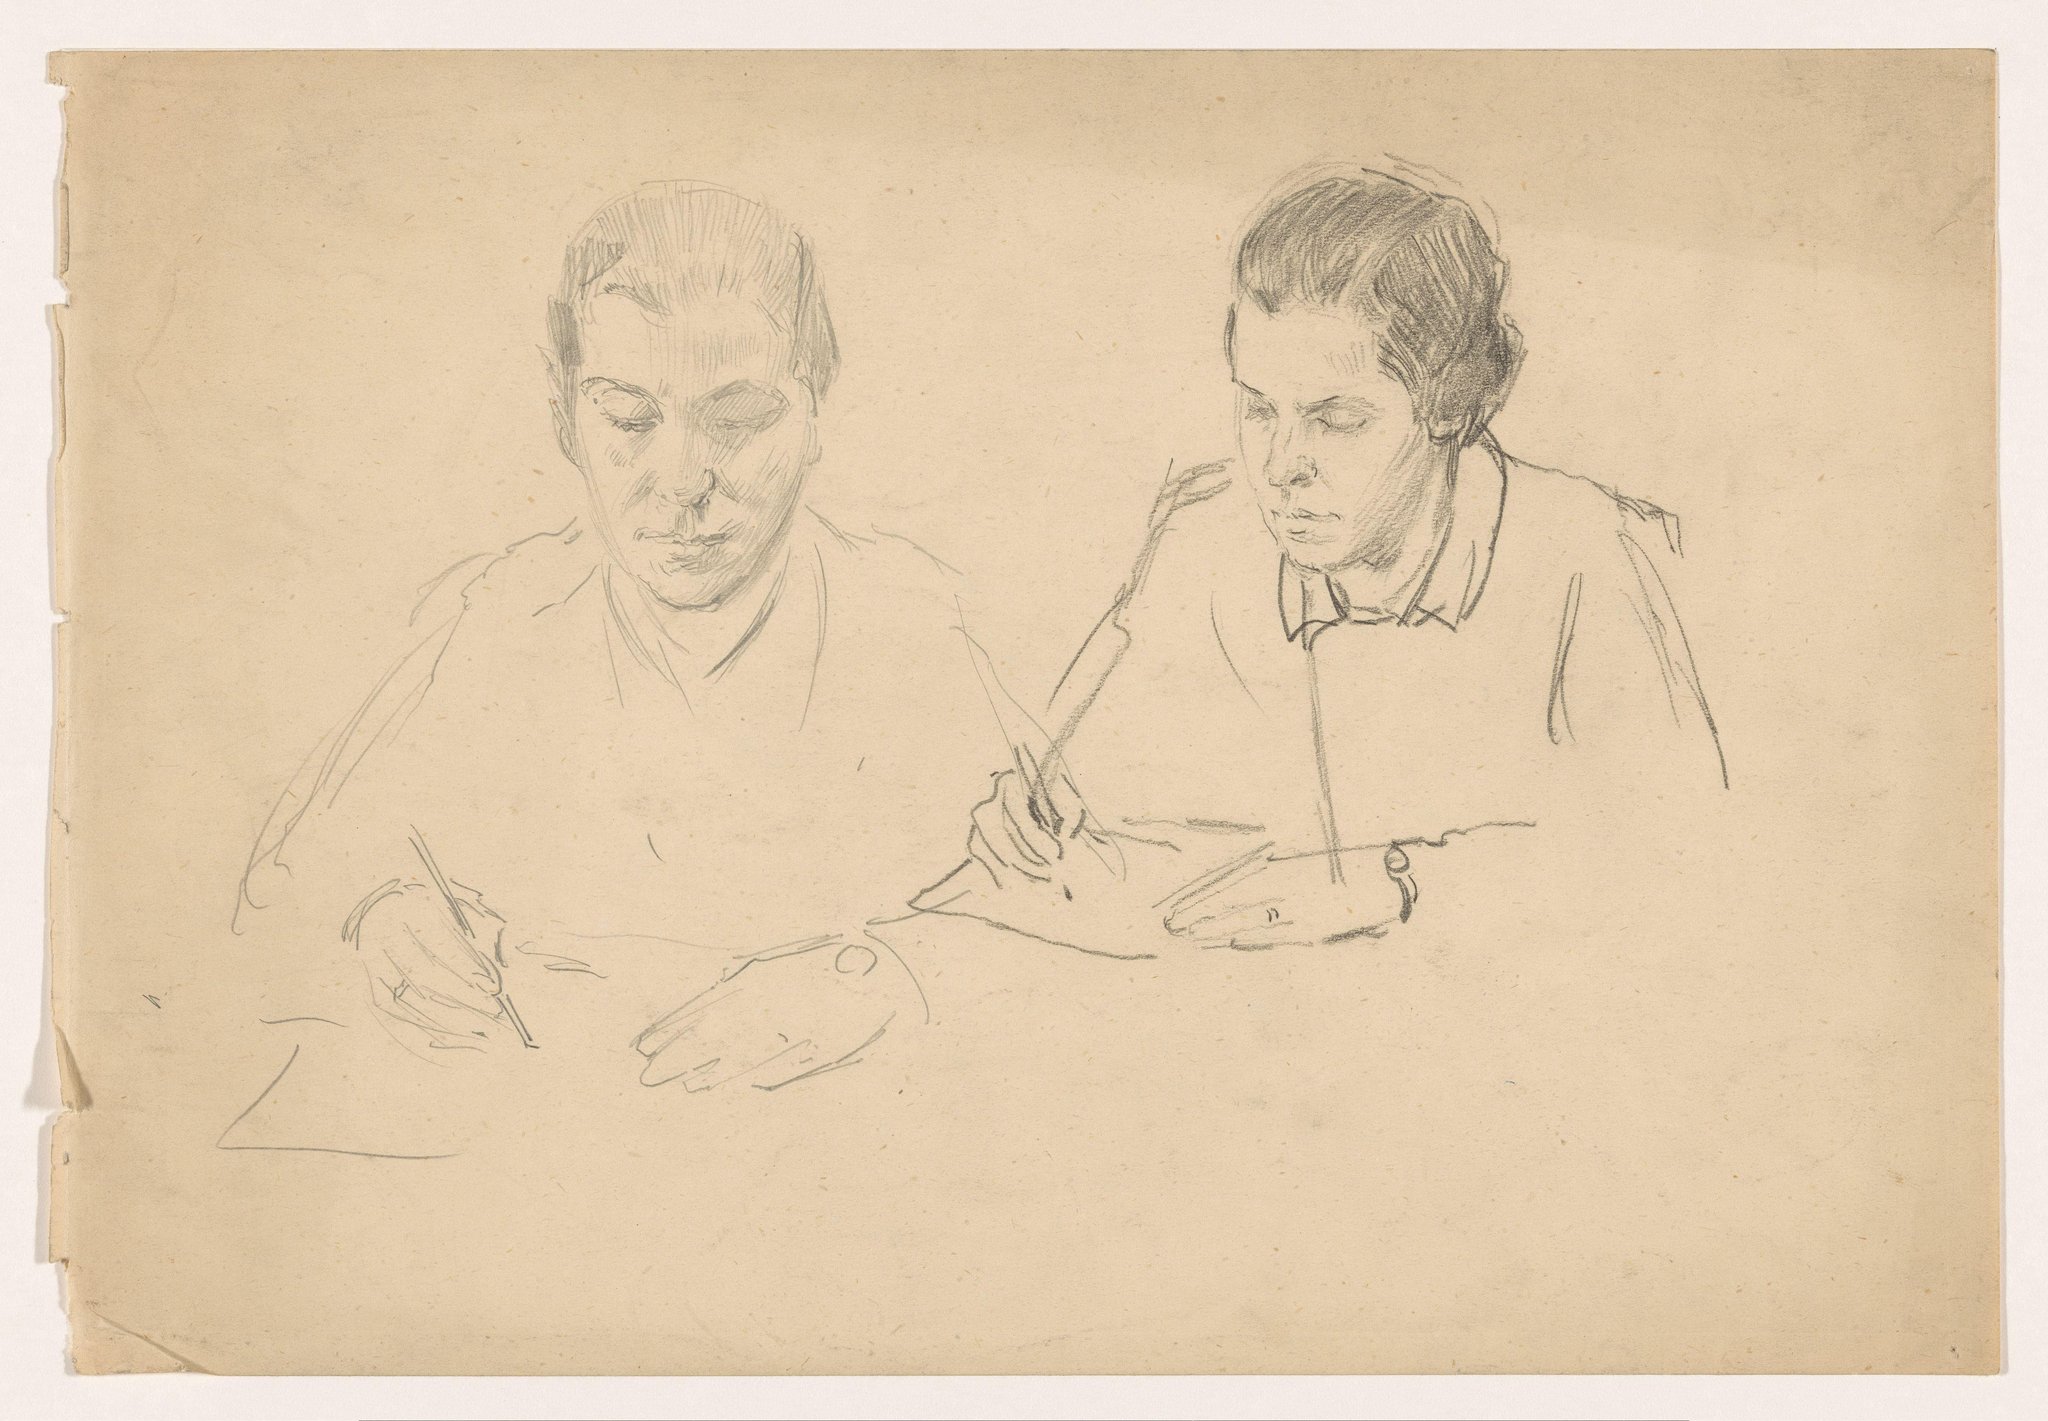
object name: drawing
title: Portretstudies voor het (onvoltooide) schilderij van de Nederlandse rechtbank in Londen, juni 1942: Mr E.P.A. Akkerman-Weber.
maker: anton abraham van anrooy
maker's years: 1870-1949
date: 1942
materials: paper, pencil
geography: westminster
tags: london, anton abraham van anrooy, historical persons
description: Voortekening uit een serie van 11. Twee portretstudies in potlood van de griffier van de rechtbank, mevrouw Mr E.P.A. Akkerman-Weber.